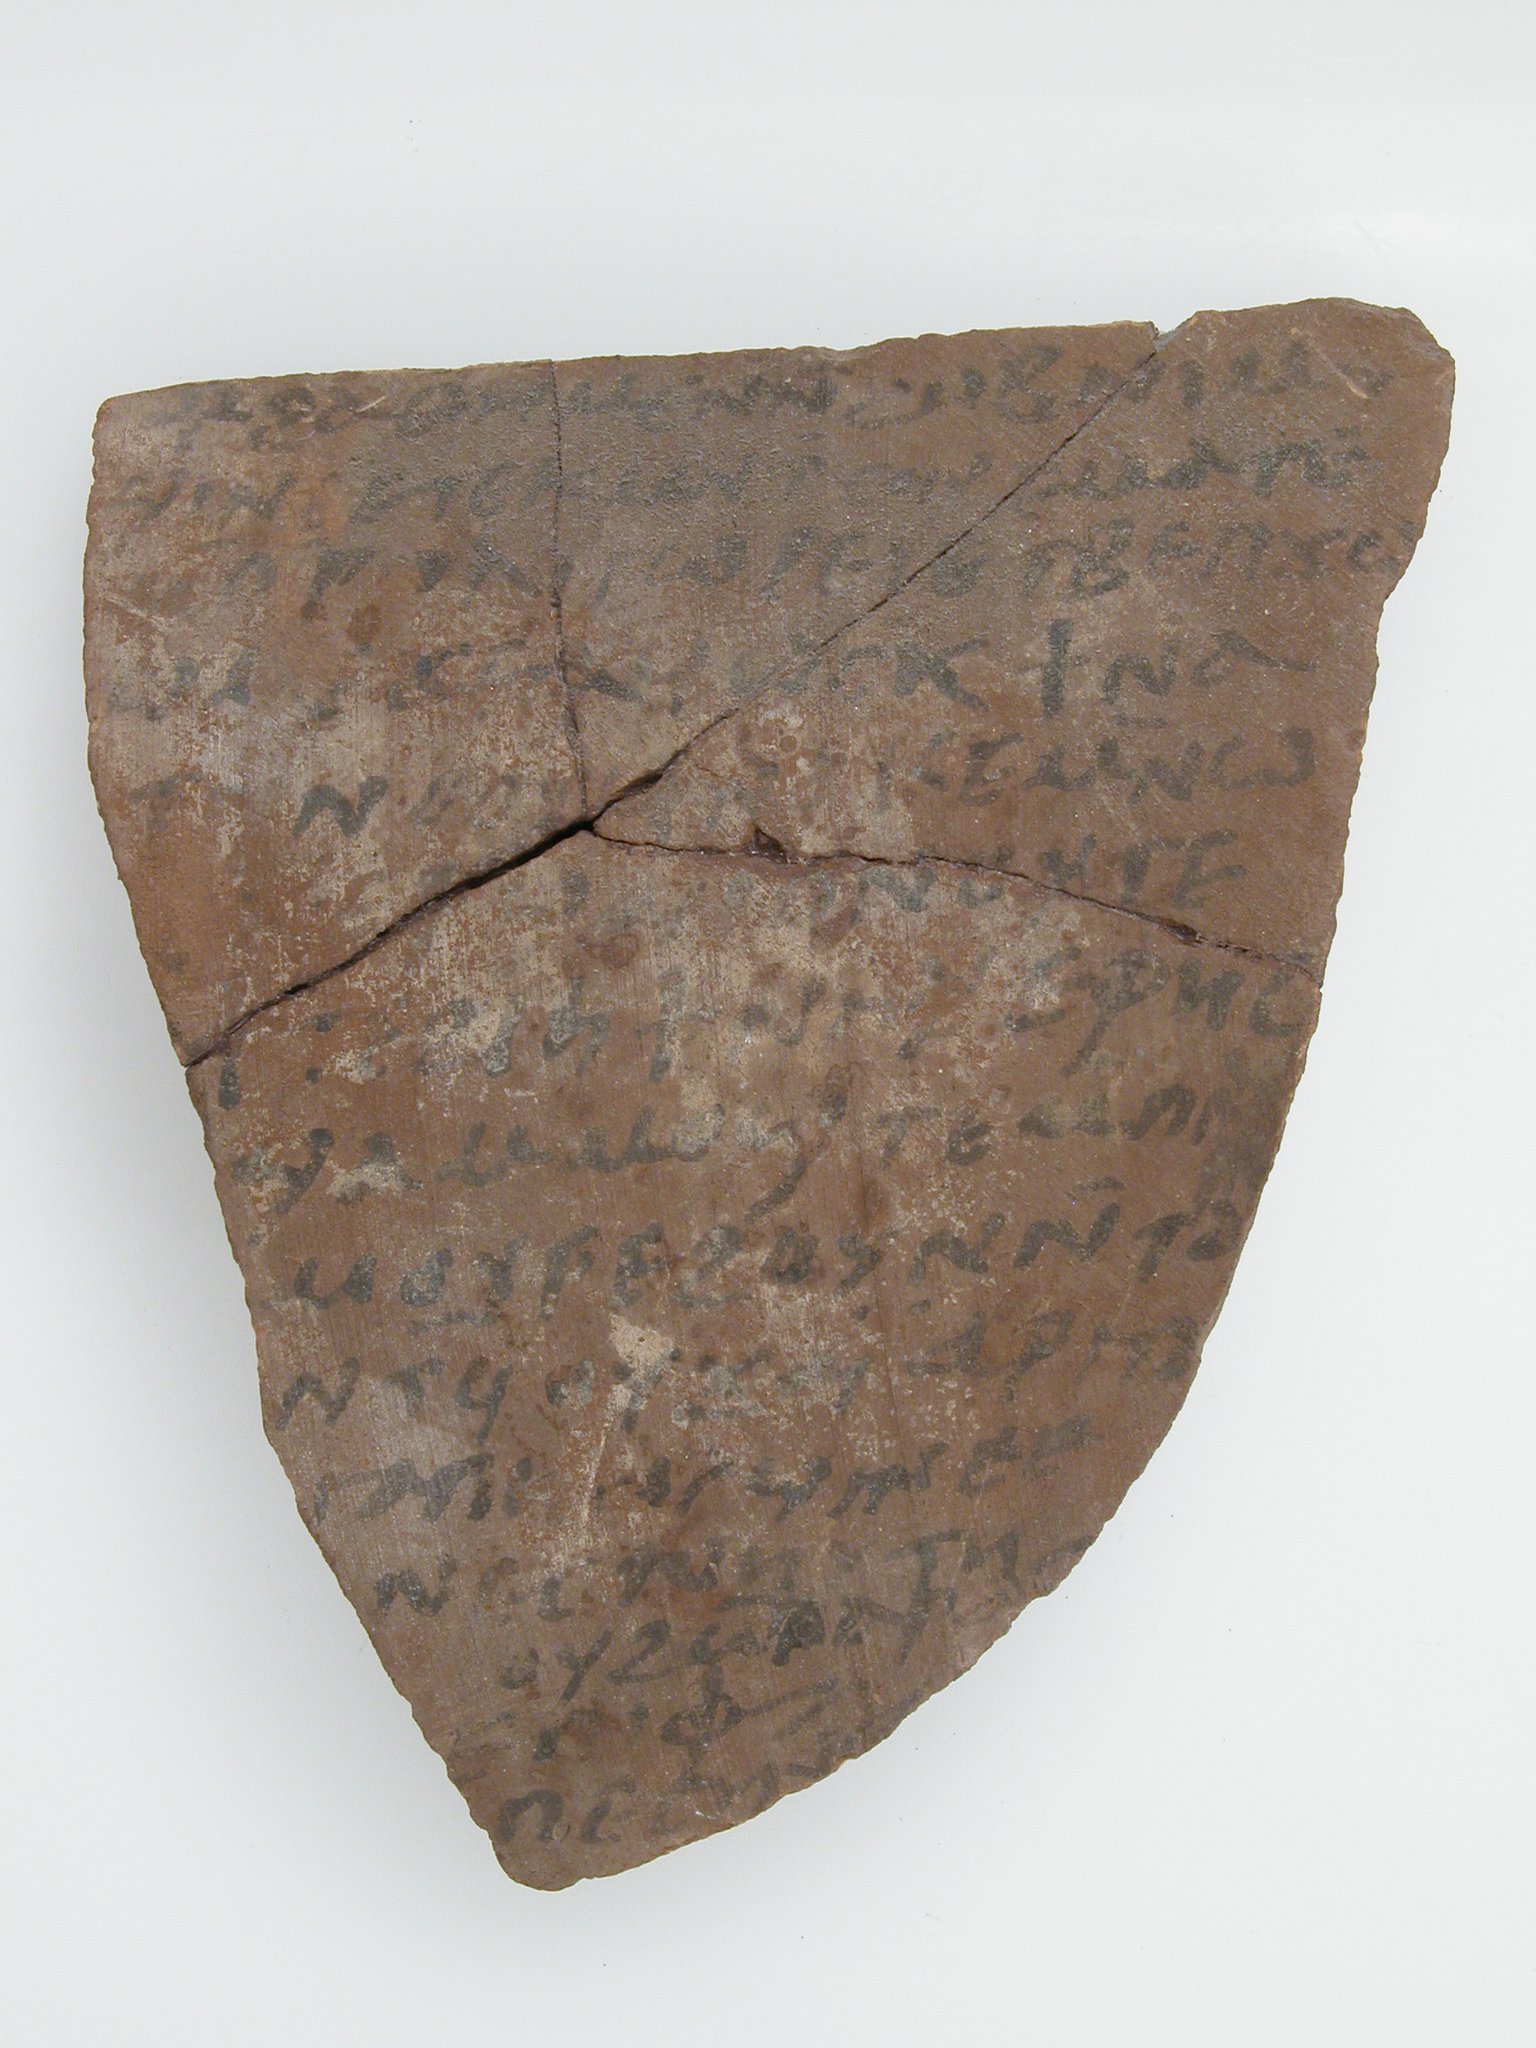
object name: ostrakon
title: Ostrakon with a Letter from Pesenthius to Epiphanius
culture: coptic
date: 600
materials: ink, pottery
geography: egypt